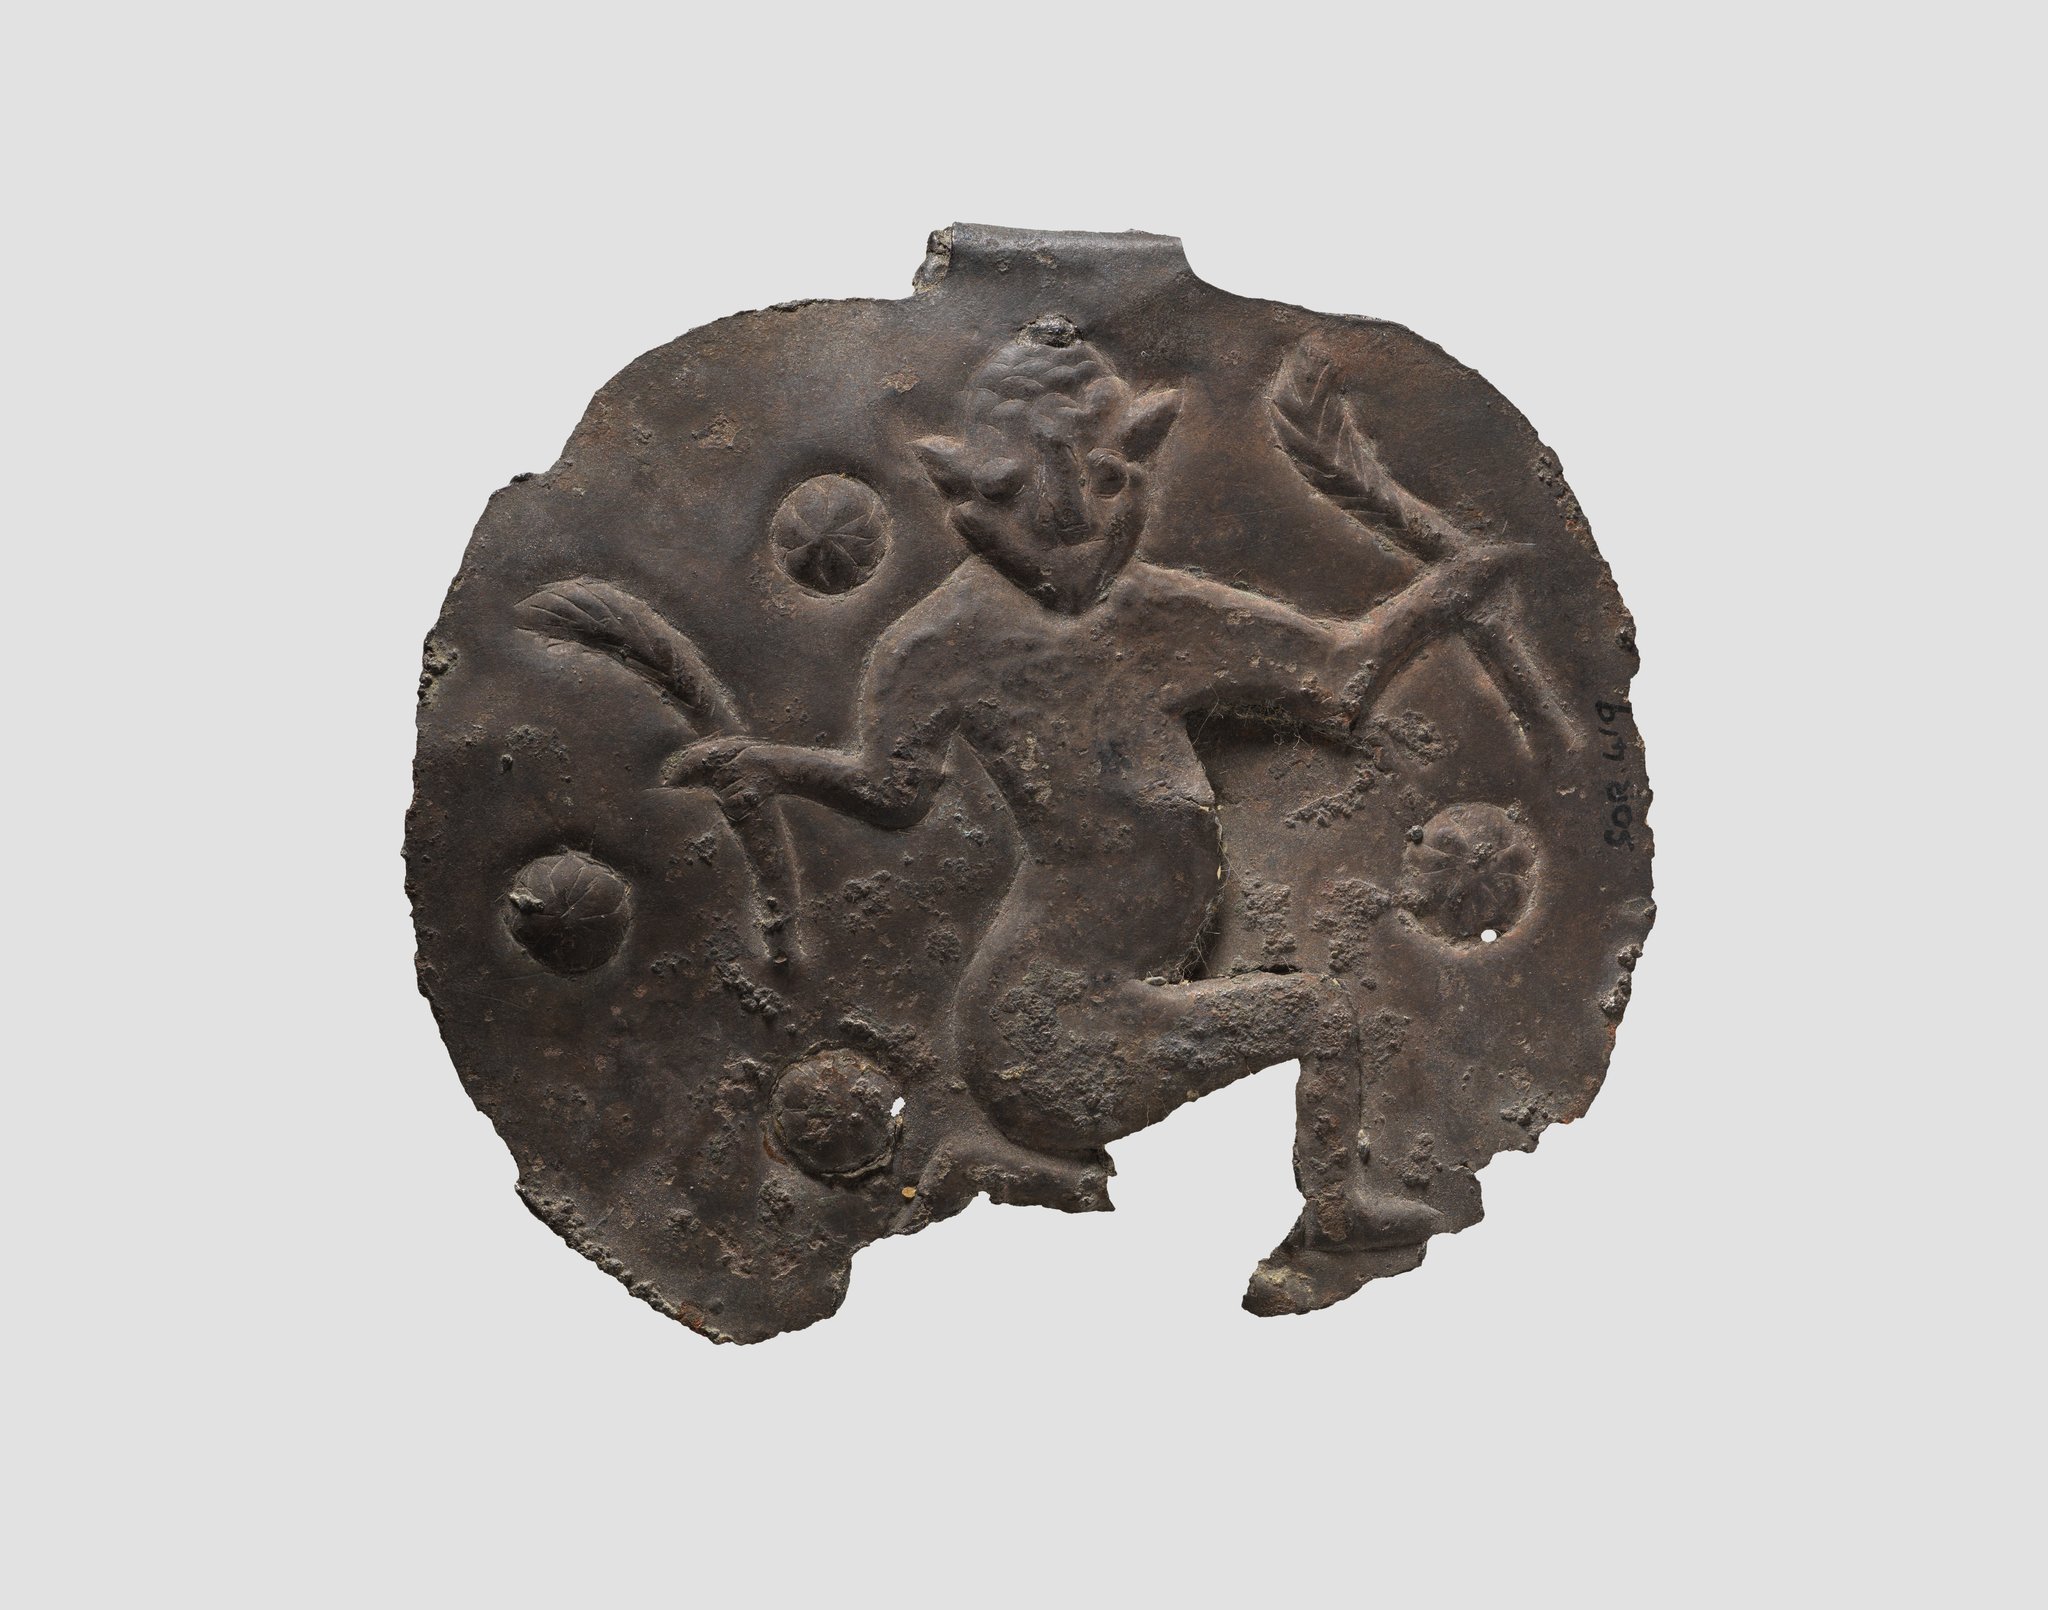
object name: pendant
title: Pendant with a kneeling male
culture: iranian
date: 800-601 BCE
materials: bronze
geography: iran, luristan